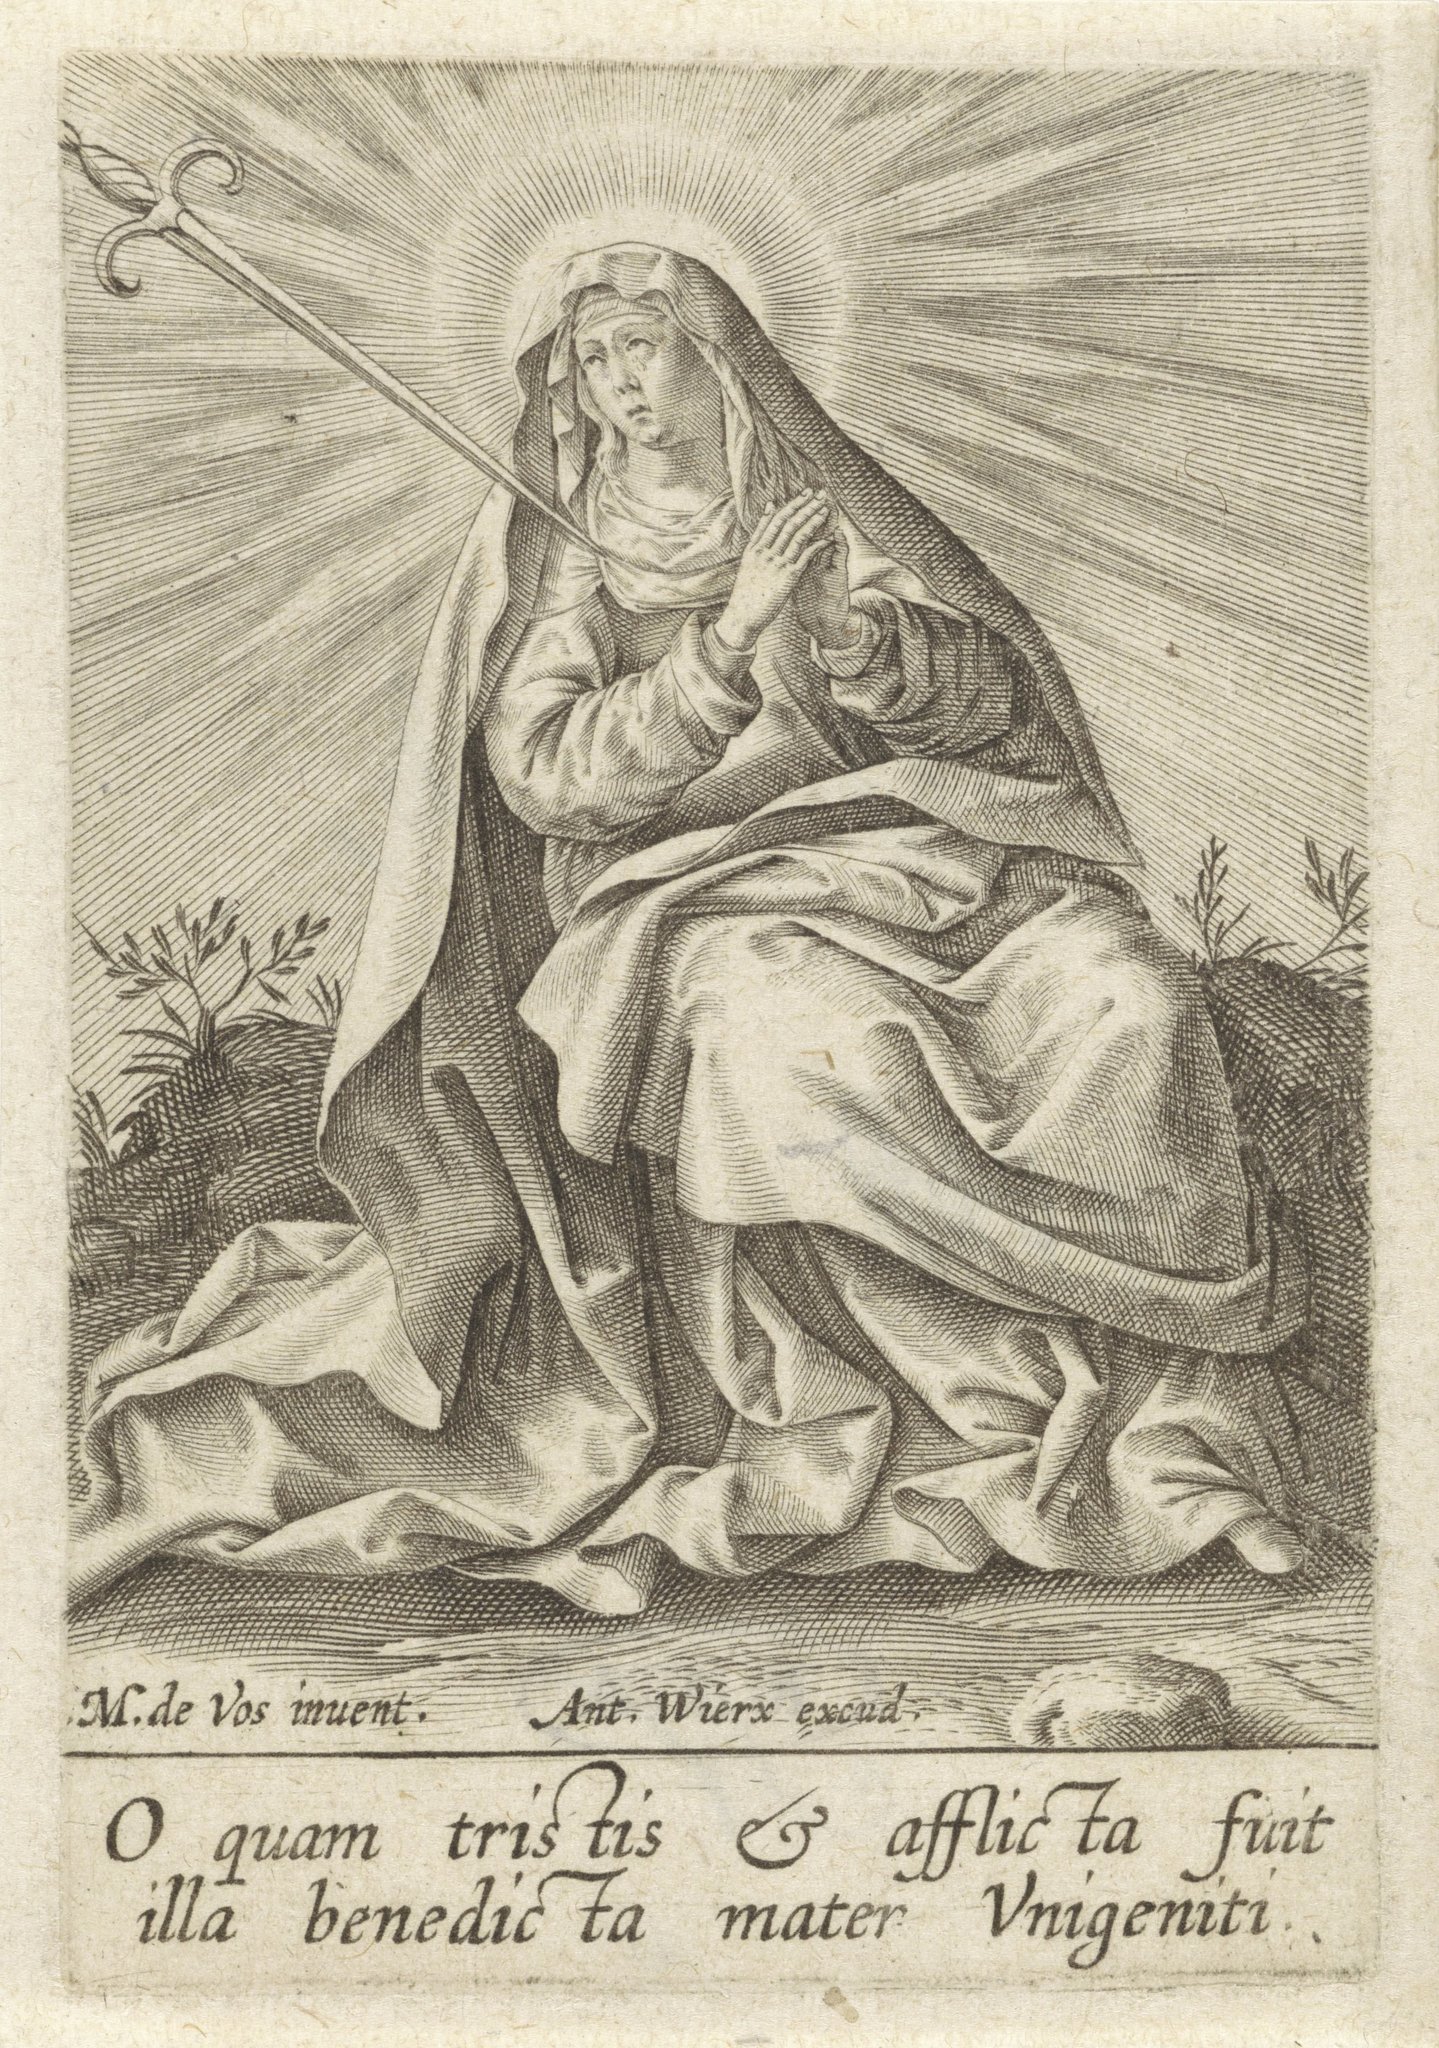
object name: print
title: Maria als Mater Dolorosa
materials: paper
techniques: engraving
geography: antwerp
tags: mary pierced by a sword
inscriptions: collector's mark: Lugt 2228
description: Maria zit met haar handen gevouwen, een zwaard door haar borst gestoken, in een landschap. In de marge een tweeregelig onderschrift in het Latijn.